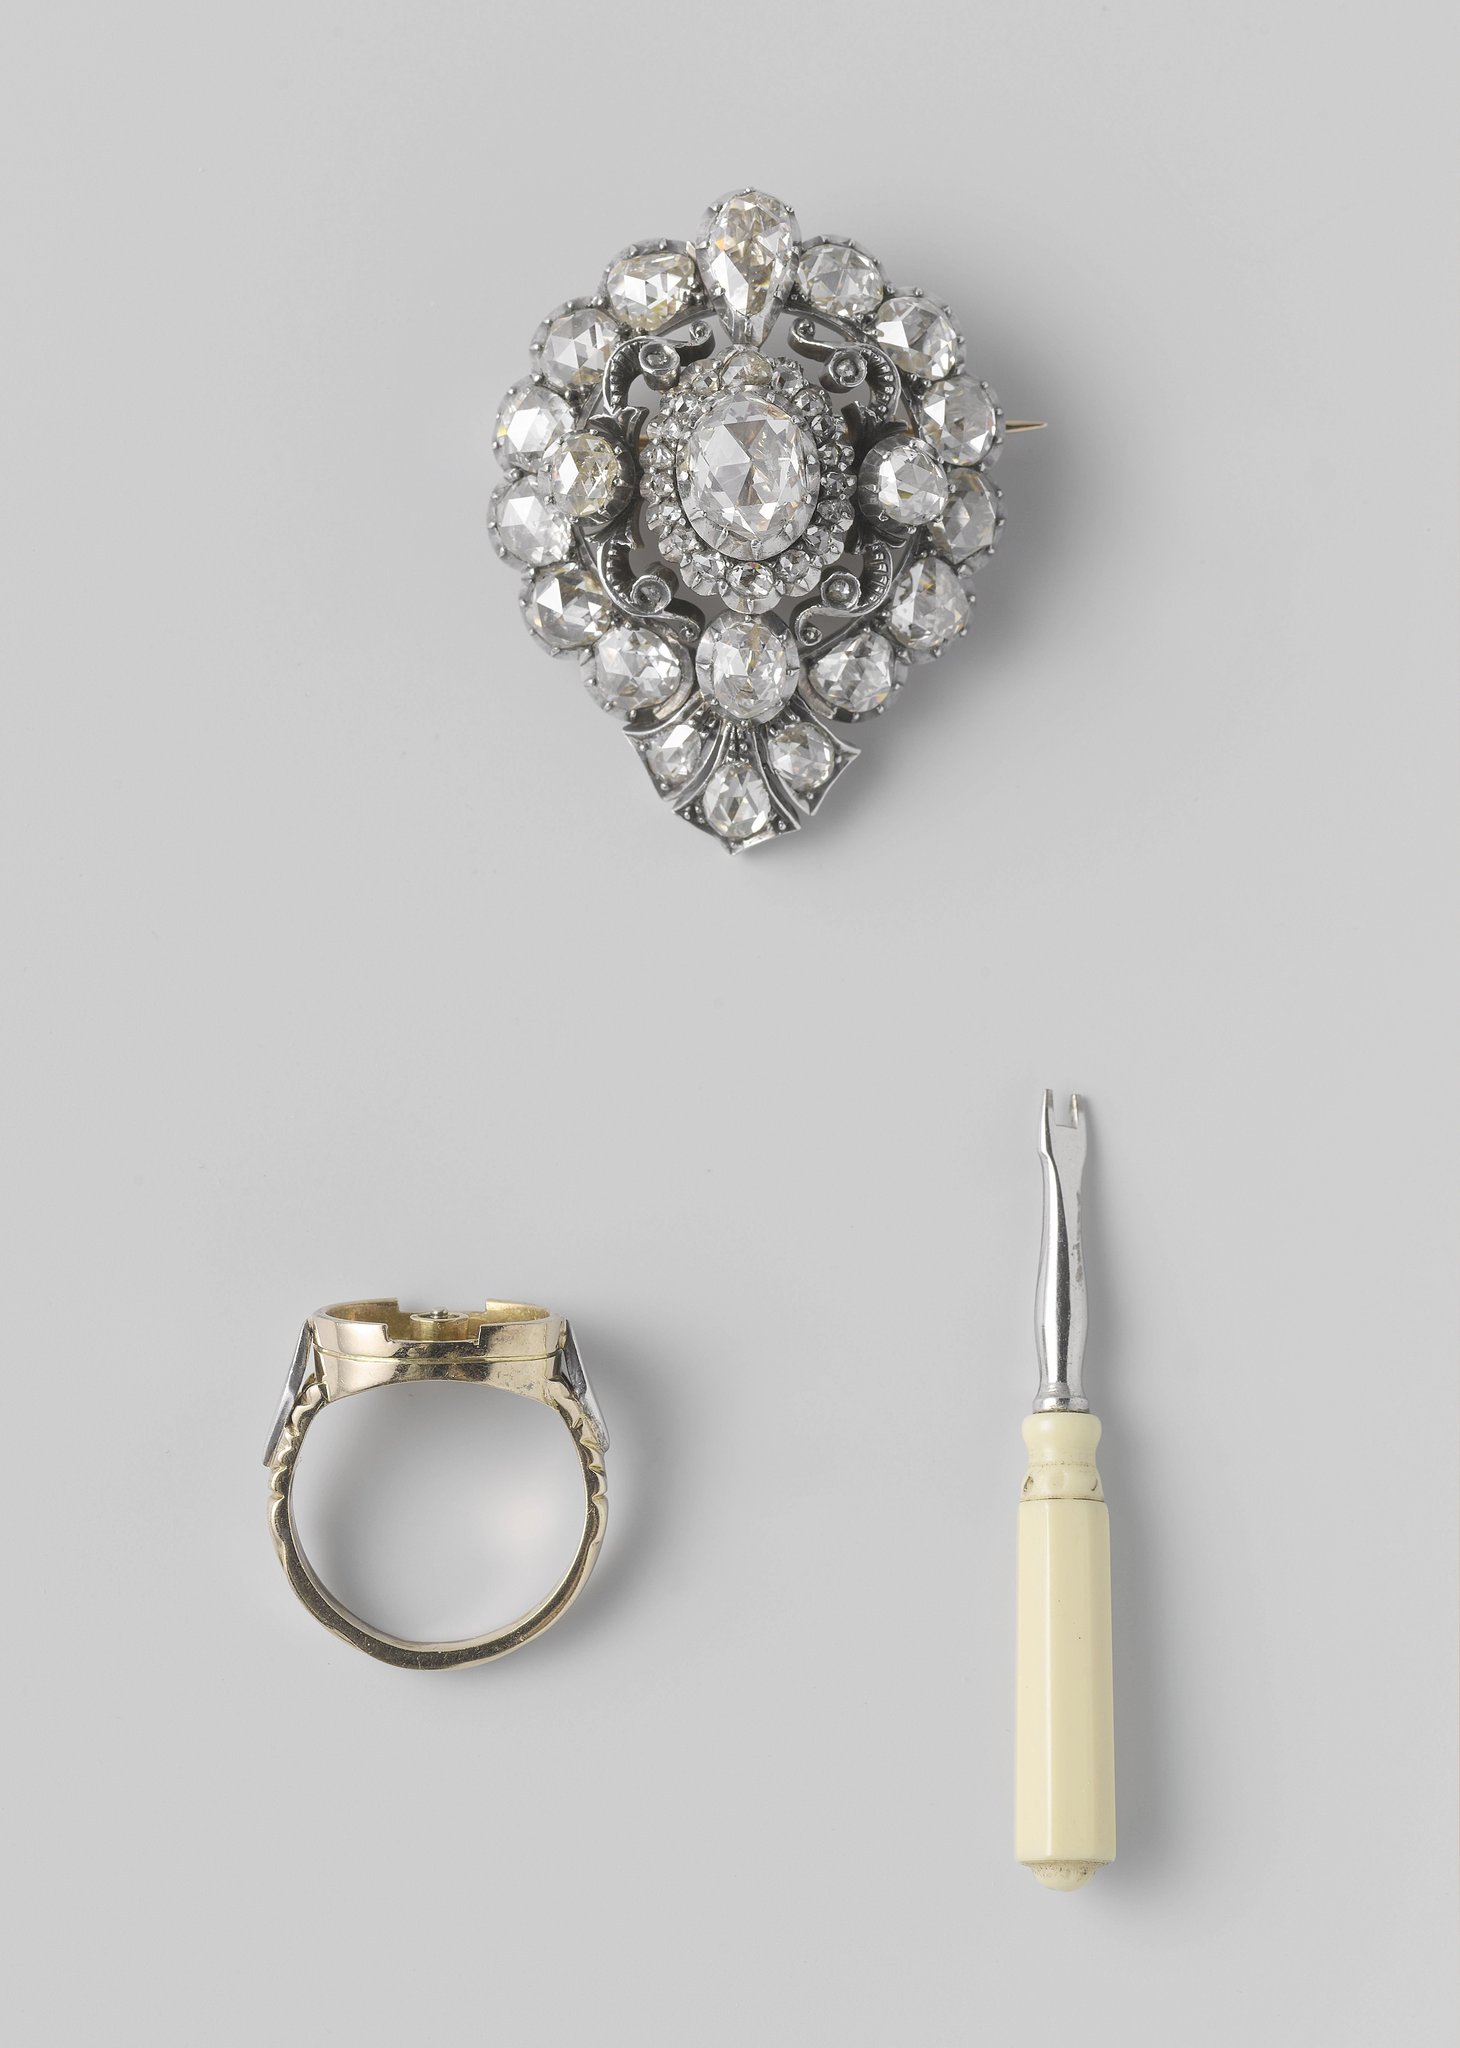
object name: screwdriver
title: Schroevendraaier met handvat van been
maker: Anonymous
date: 1856-1862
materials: bone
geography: netherlands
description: Behorende bij een broche van goud met 19 diamanten, en een ring, waarin de centrale diamant kan worden gezet.